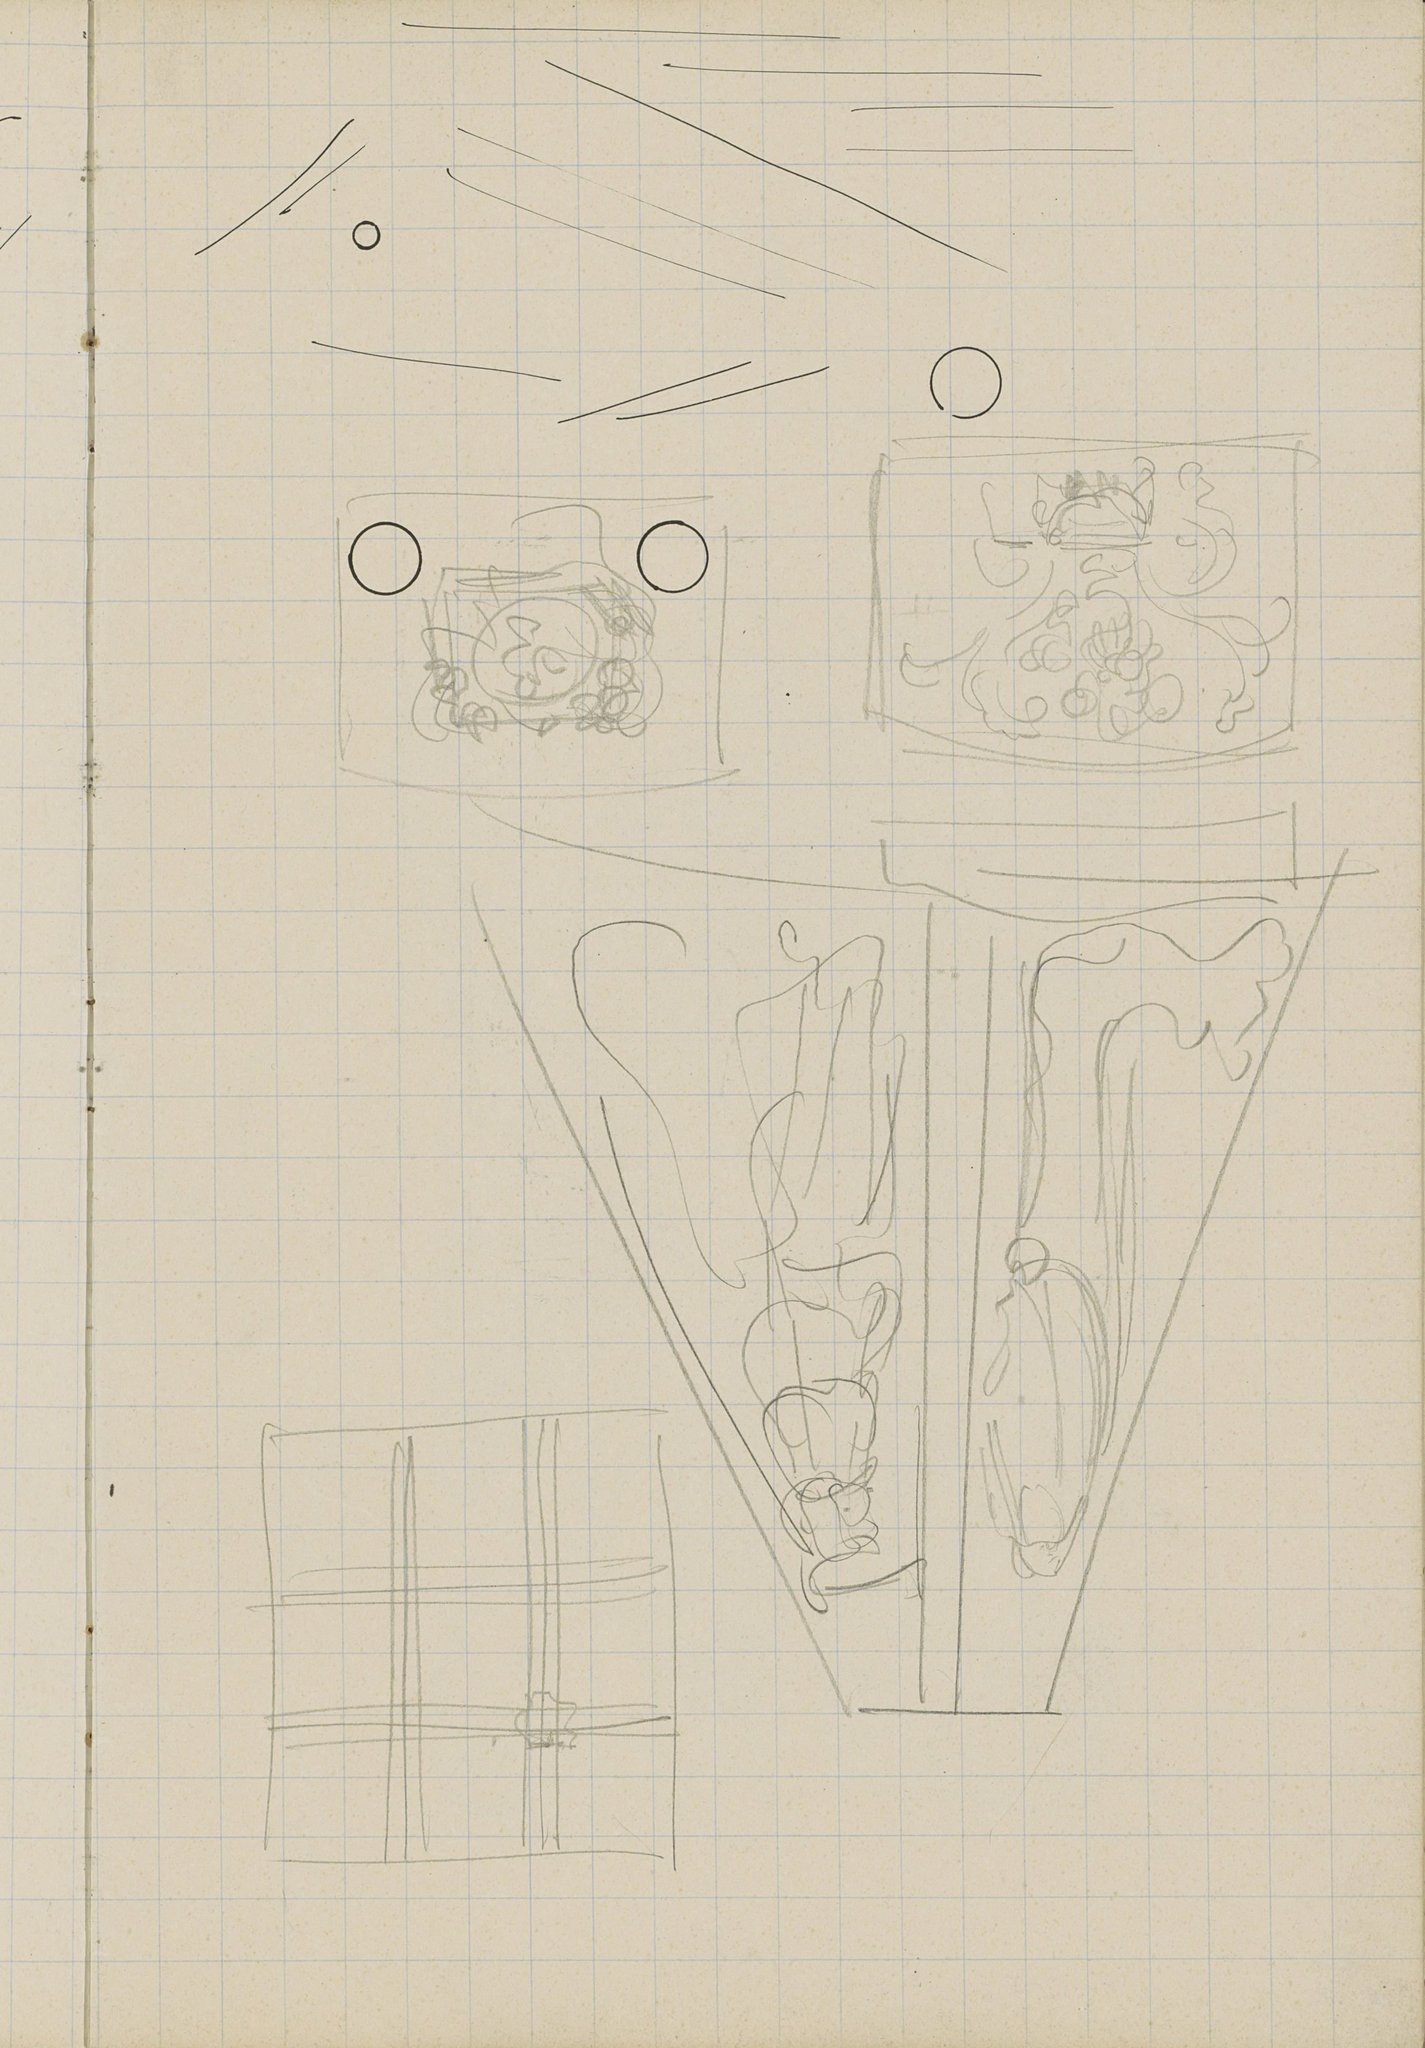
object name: sketchbook leaf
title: Ornamenten met lijnen en patronen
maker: carel adolph lion cachet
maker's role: draughtsman, print maker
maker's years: 1864-1945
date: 1925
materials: ink, pencil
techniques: pen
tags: ornaments ~ art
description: Tevens lijnen en cirkels. Blad 4 recto uit een schetsboek met 11 bladen.